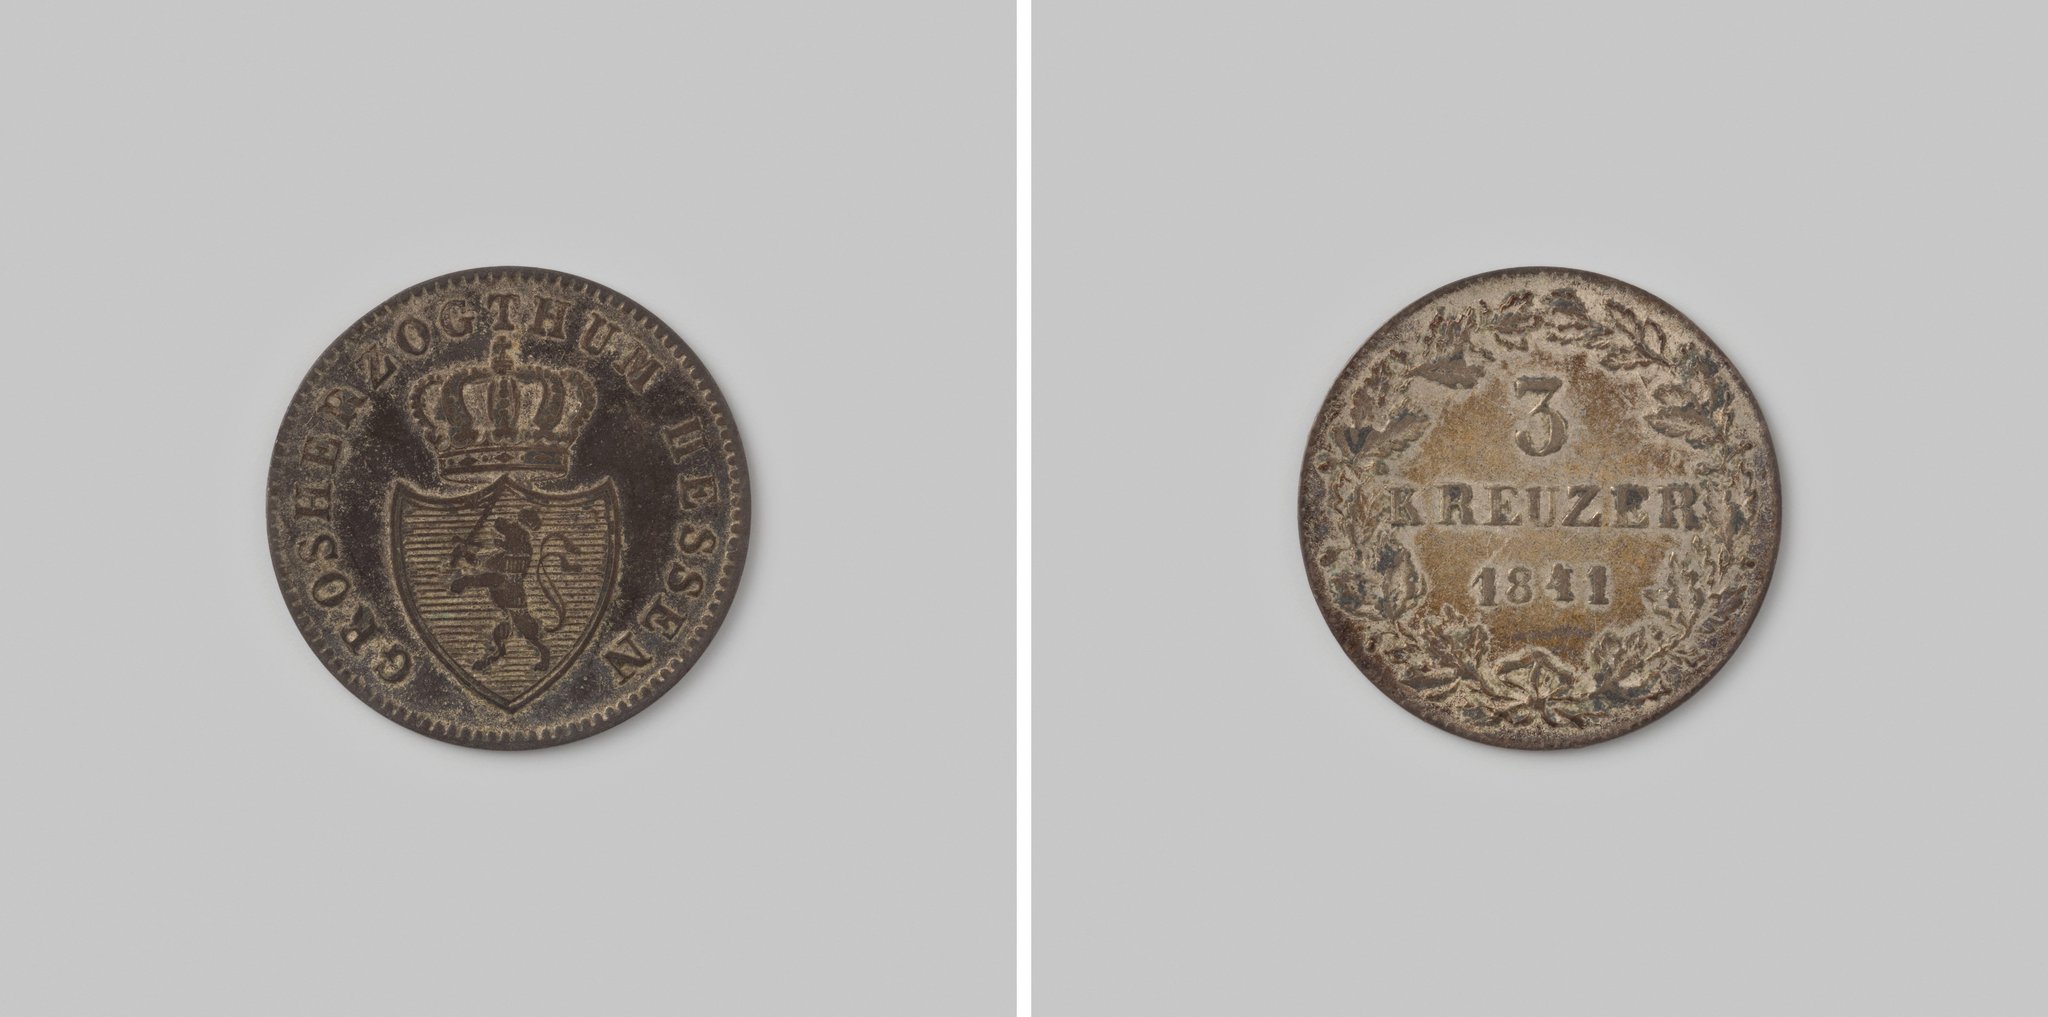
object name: coin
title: Groothertogdom Hessen, Ludwig II, 3 Kreuzer, 1841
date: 1841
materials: silver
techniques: striking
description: Zilveren munt. Voorzijde: gekroond wapenschild. Keerzijde: binnen twee samengebonden takken waarde-aanduiding in twee regels, waaronder jaartal. Kartelrand.